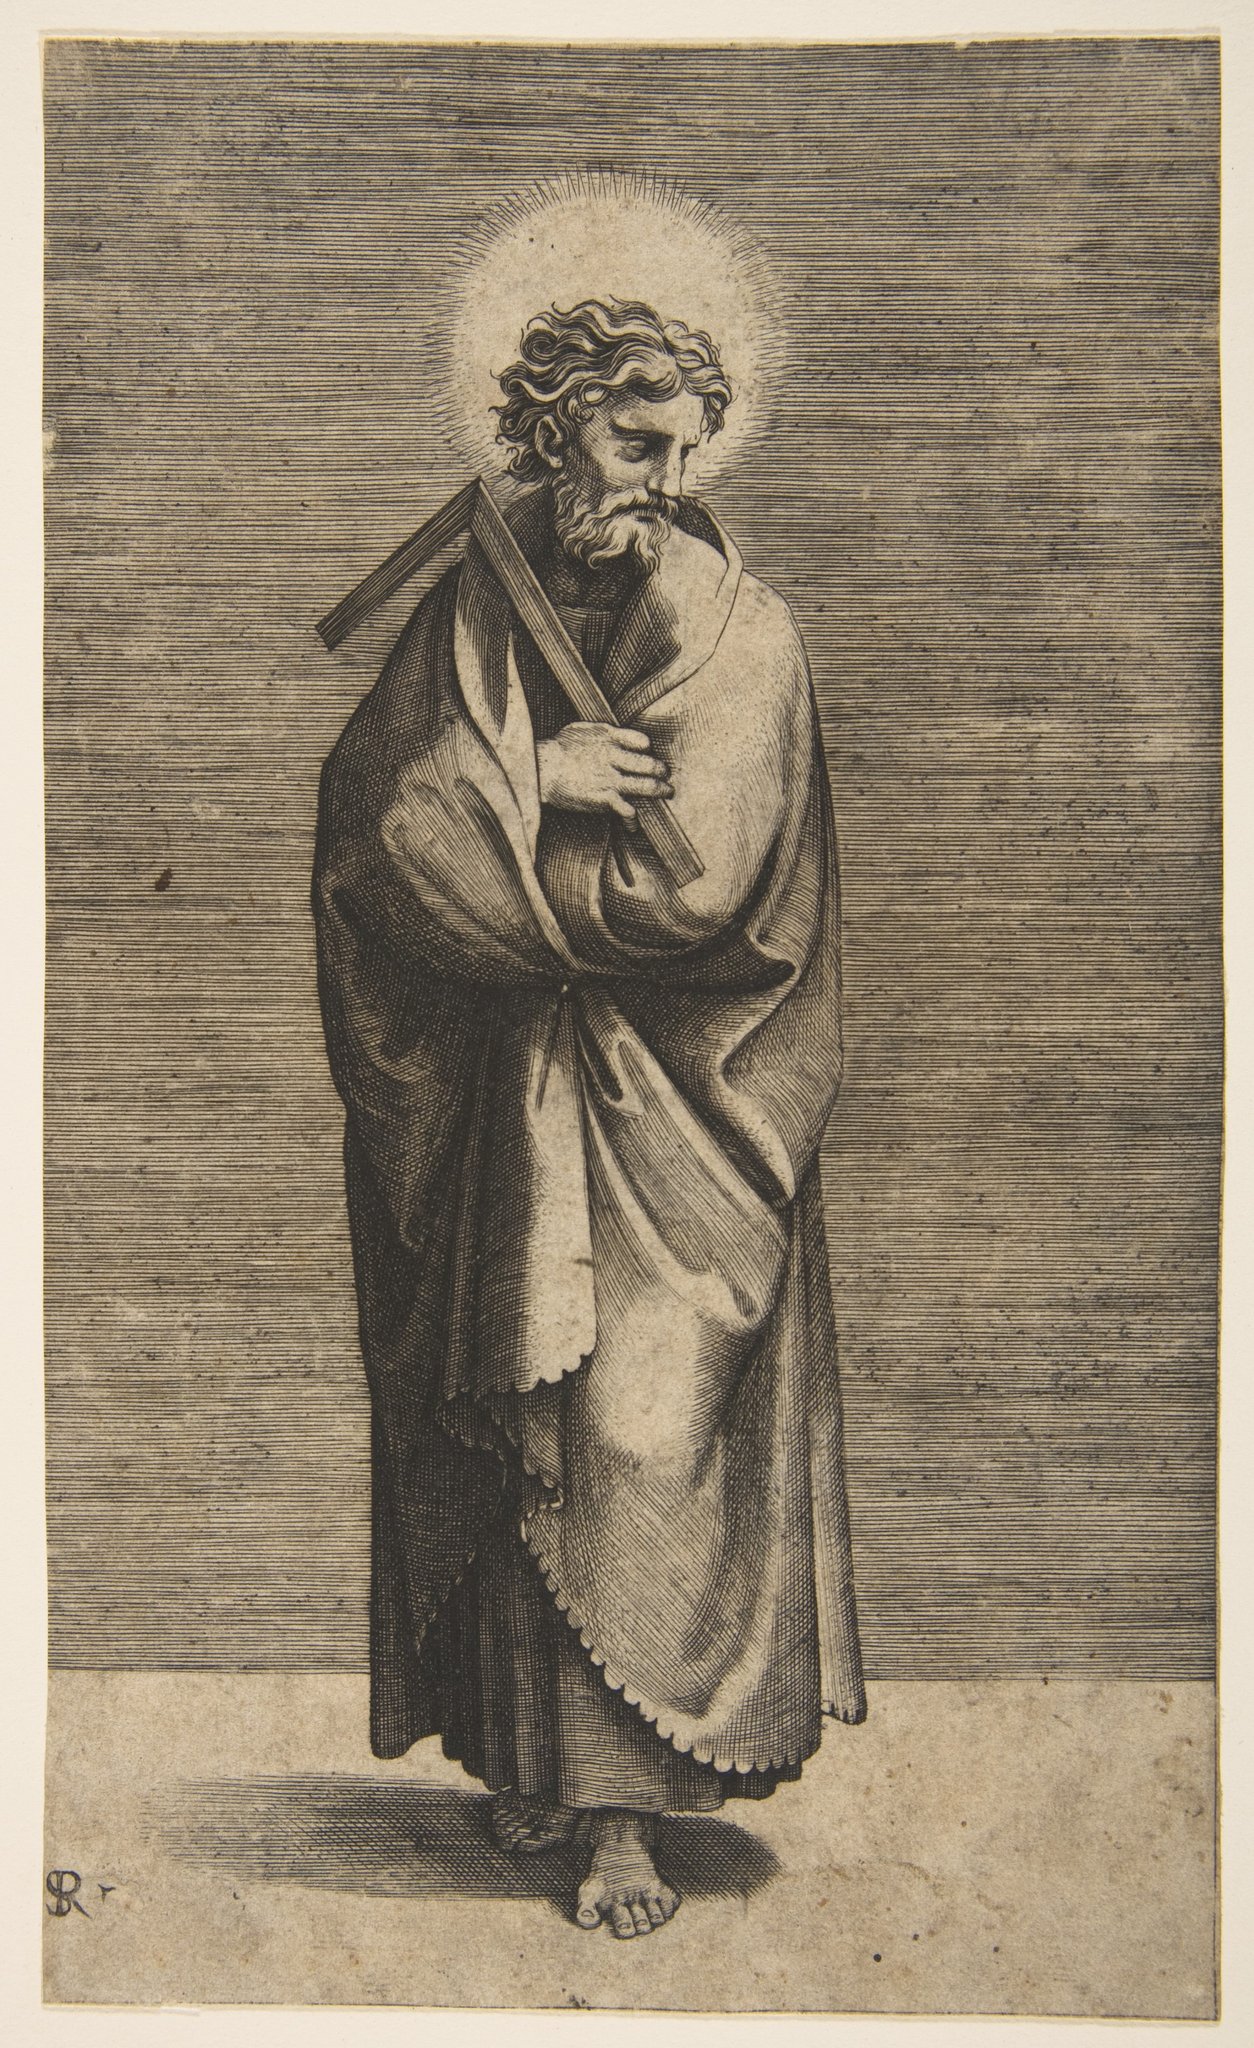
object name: print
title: Saint Thomas holding a square rule, his head turned to the right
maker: marco dente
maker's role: artist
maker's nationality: italian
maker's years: 1515-1527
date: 1515-1527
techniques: engraving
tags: saints